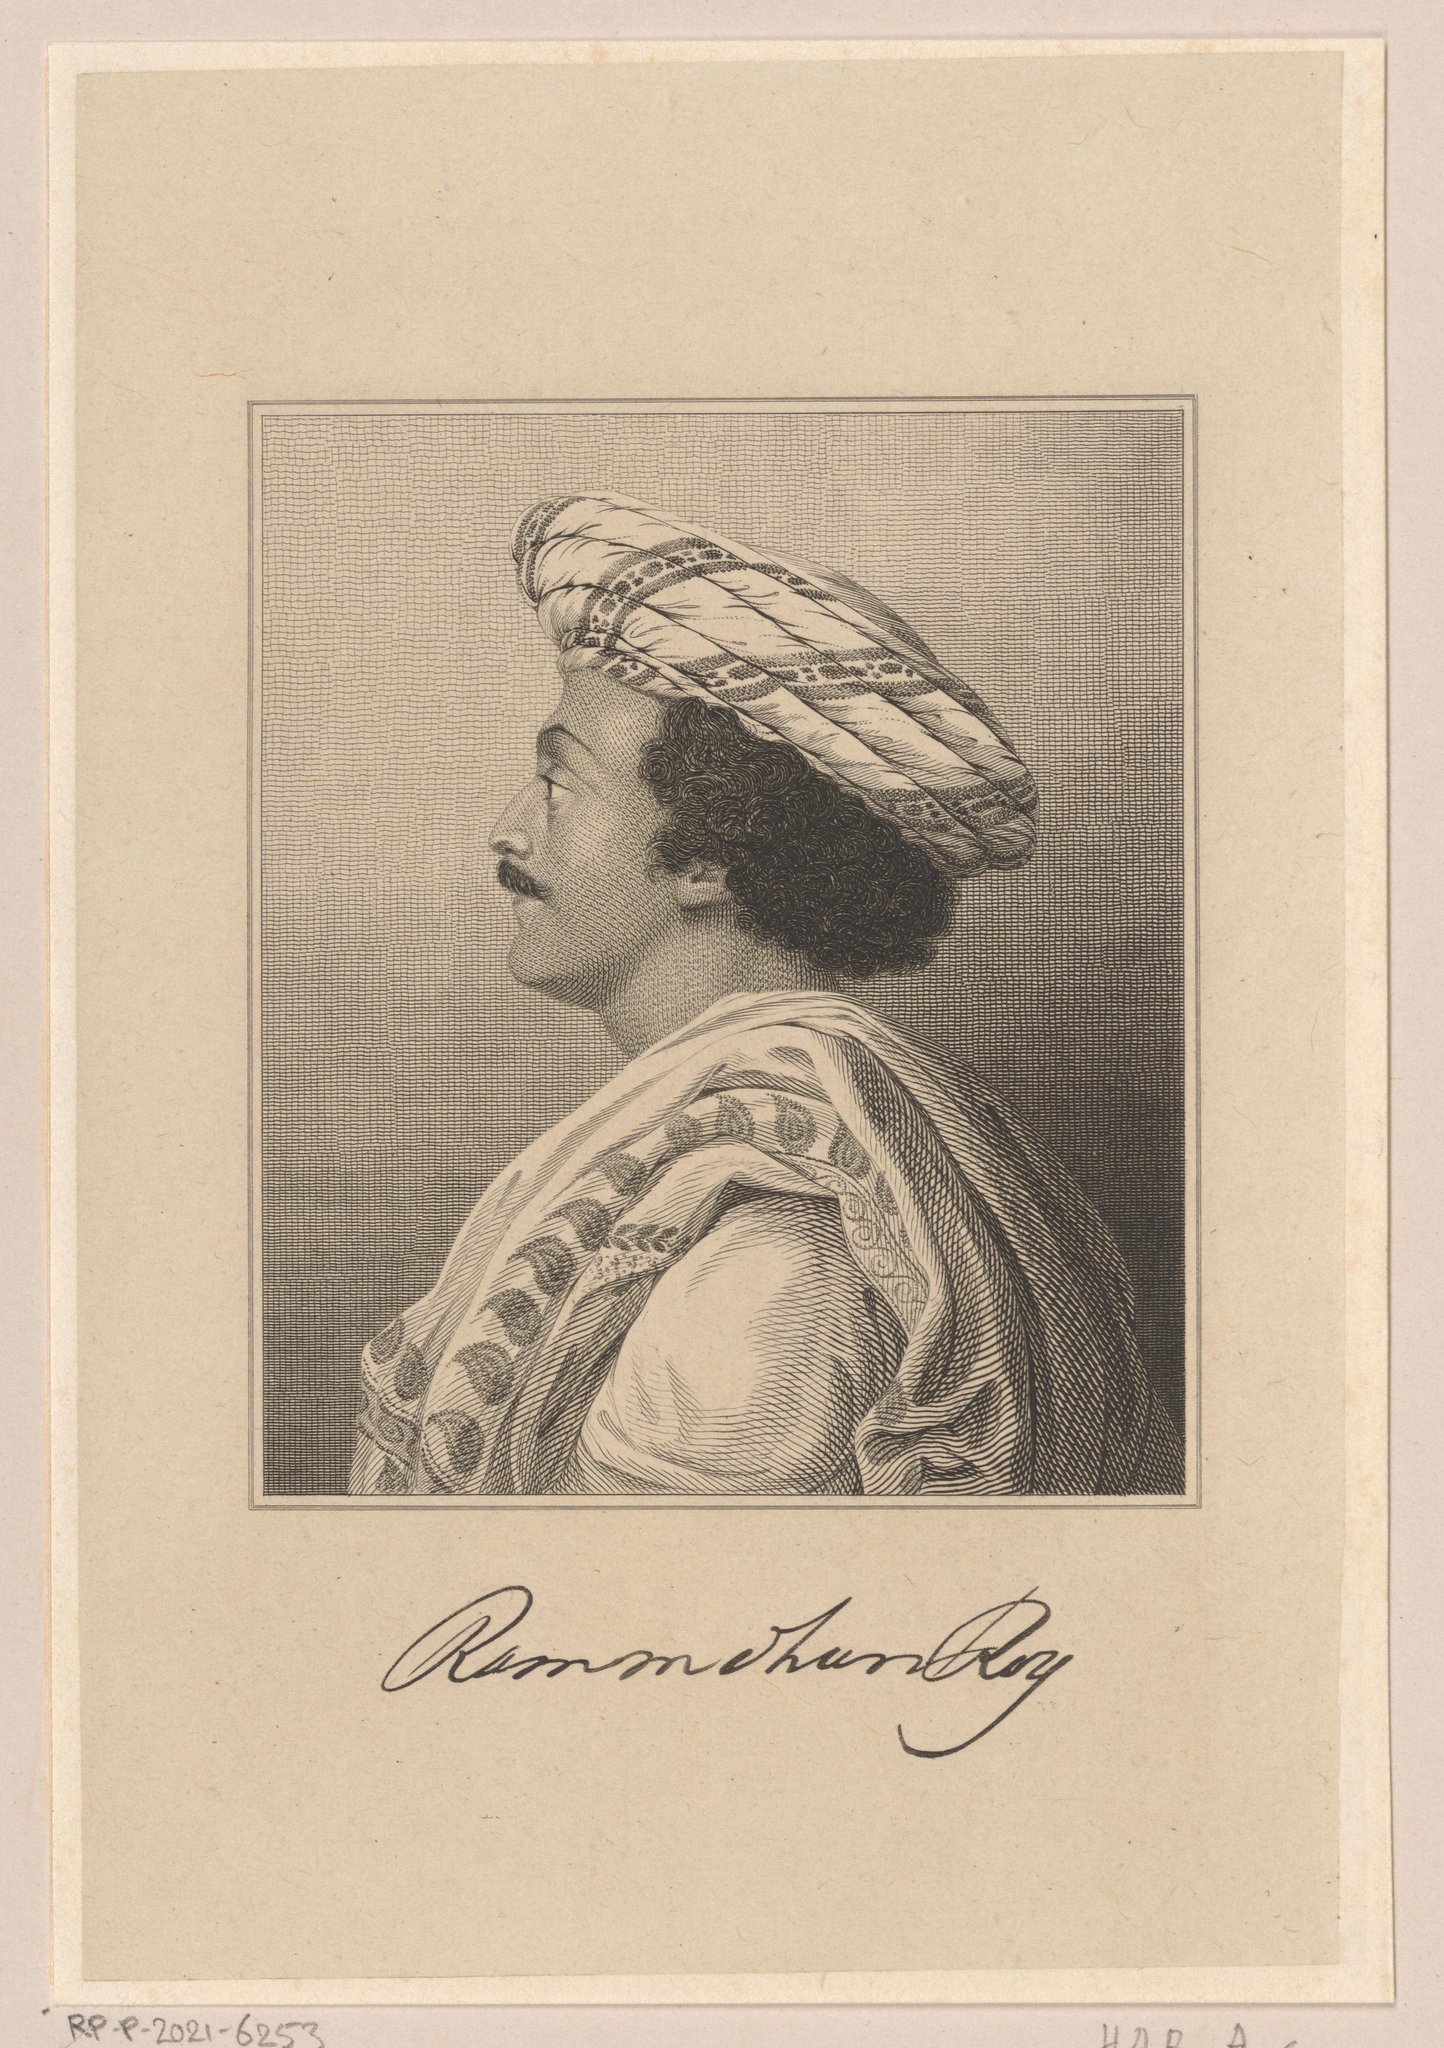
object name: print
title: Portret van een onbekende man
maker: Anonymous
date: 1750-1849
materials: paper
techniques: engraving, etching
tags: head-gear: turban, historical persons not known by name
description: Onder het portret een facsimile van de handtekening van de geportretteerde.